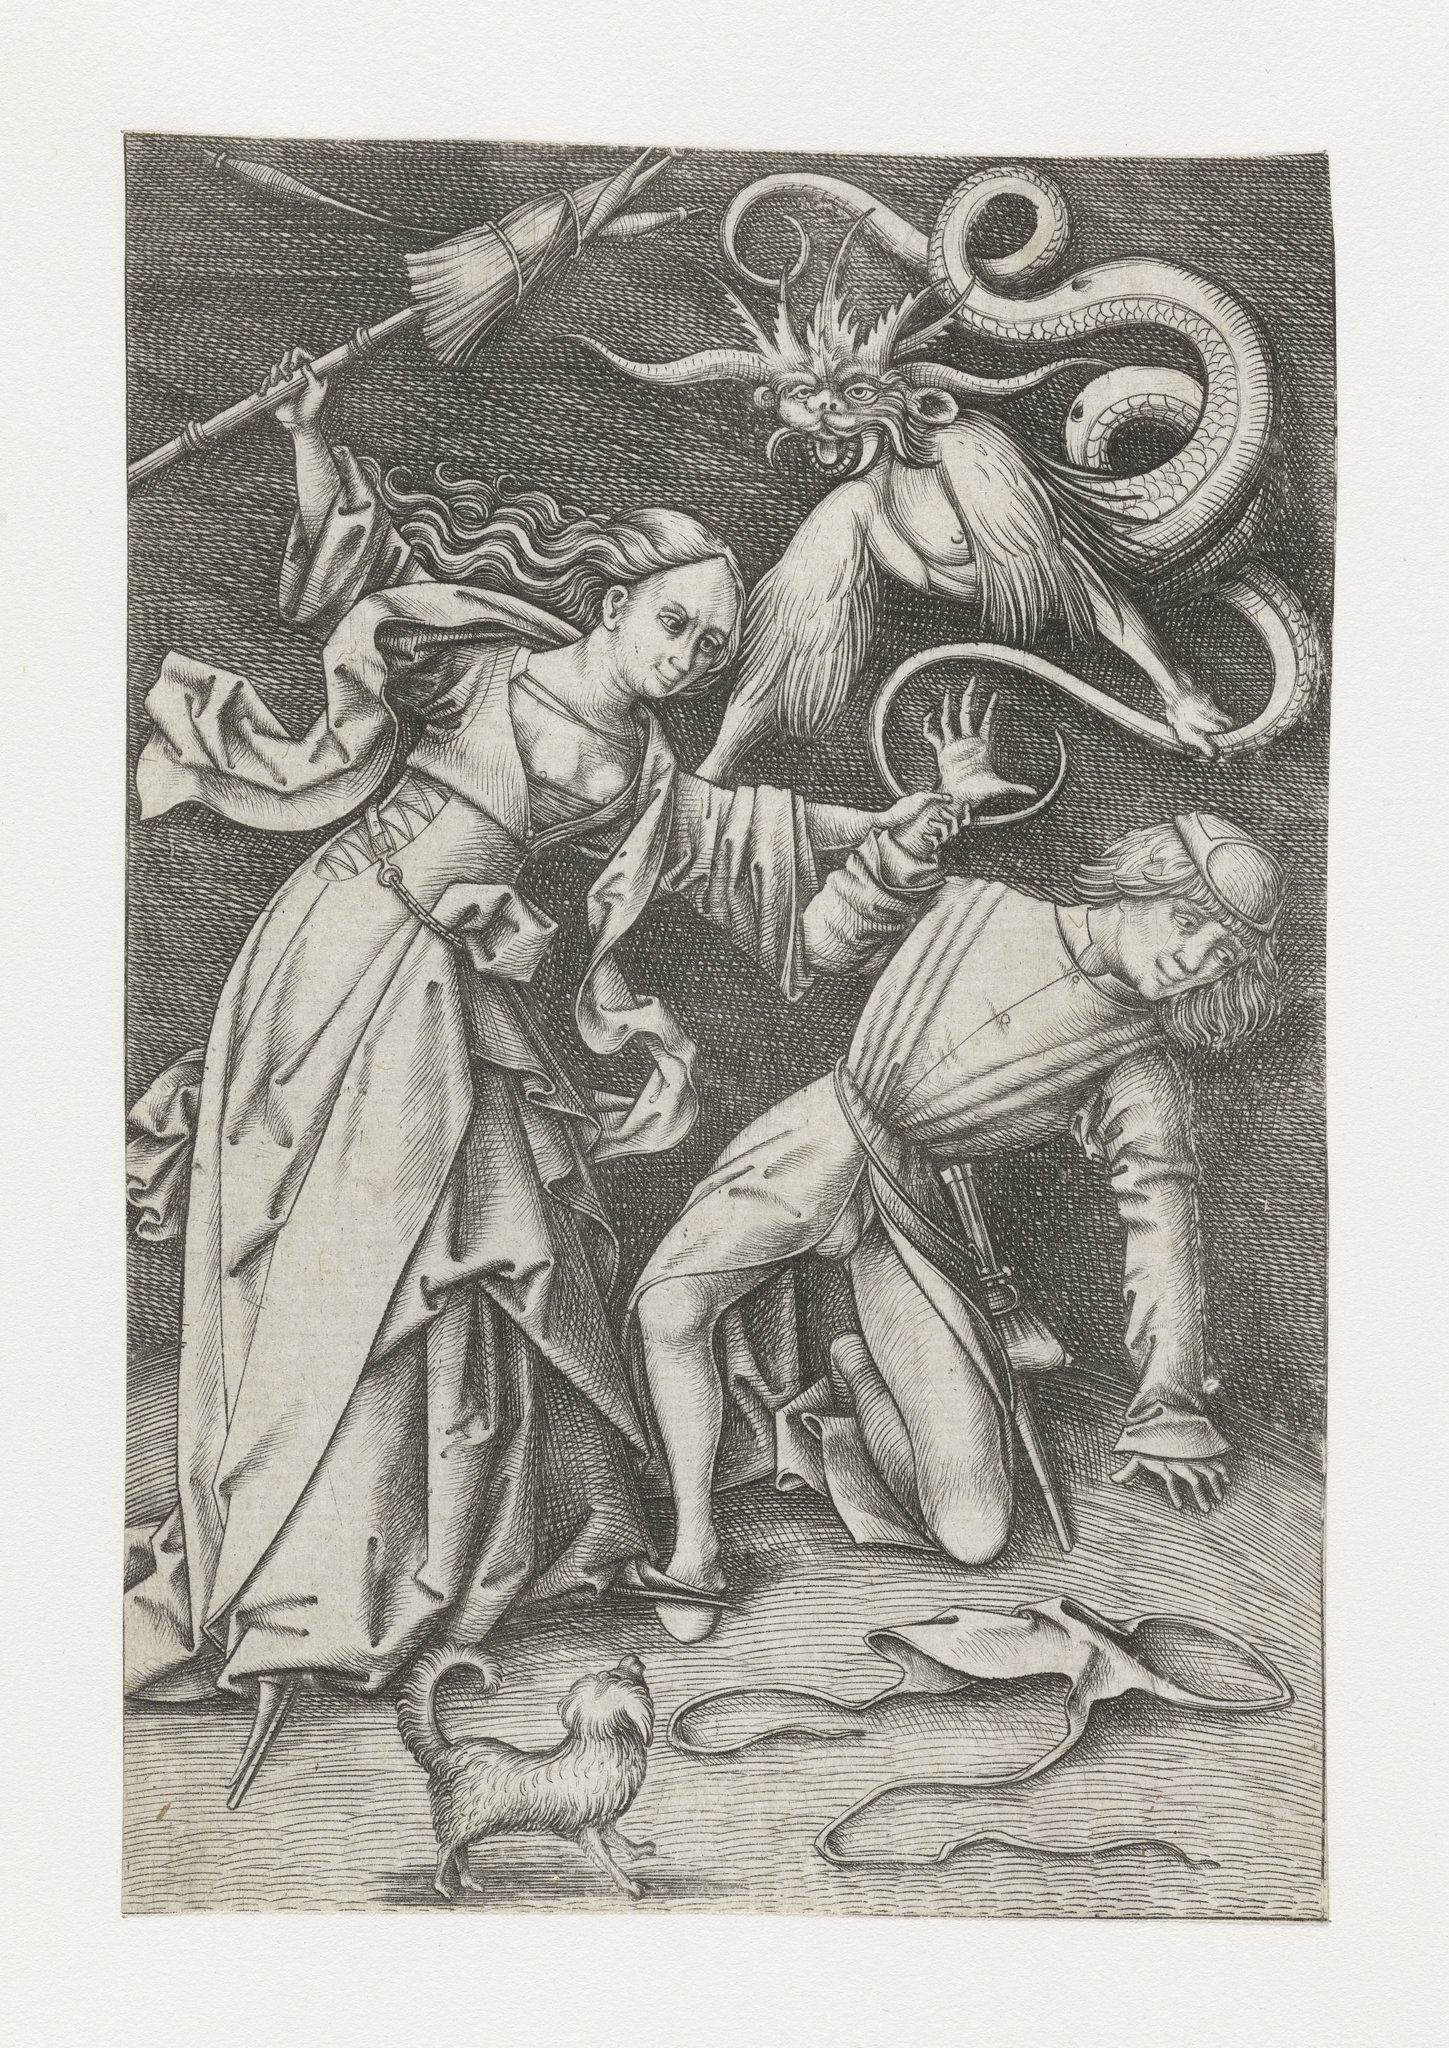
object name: print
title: Scènes uit het dagelijks leven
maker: israhel van meckenem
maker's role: print maker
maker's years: 1440-1517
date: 1475-1503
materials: paper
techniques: engraving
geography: bocholt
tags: belt, girdle, waistband (+ men's clothes), bag (+ men's clothes), battle for dominance in marriage ('who wears the breeches'), devils in the form of (fabulous) animals, distaff, codpiece (cover for the genitals), skirt (+ women's clothes), dress, gown (+ women's clothes), trousers, breeches, etc. (breeches) (+ men's clothes), clothing for the upper part of the body (doublet) (+ men's clothes), clothing for the upper part of the body (with name) (+ women's clothes)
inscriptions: collector's mark: Lugt 240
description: Kleding vrouw: overkleed met vetersluiting opzij en wijde mouwen. De V-vormige hals wordt bijeengehouden door 2 veters. Decolleté waarbij de borsten bijna geheel te zien zijn. Tootschoenen. Kleding man: mutsje op het hoofd, schaamkapsel. Broek op de grond. Datering kleding: ca. 1475-1485.